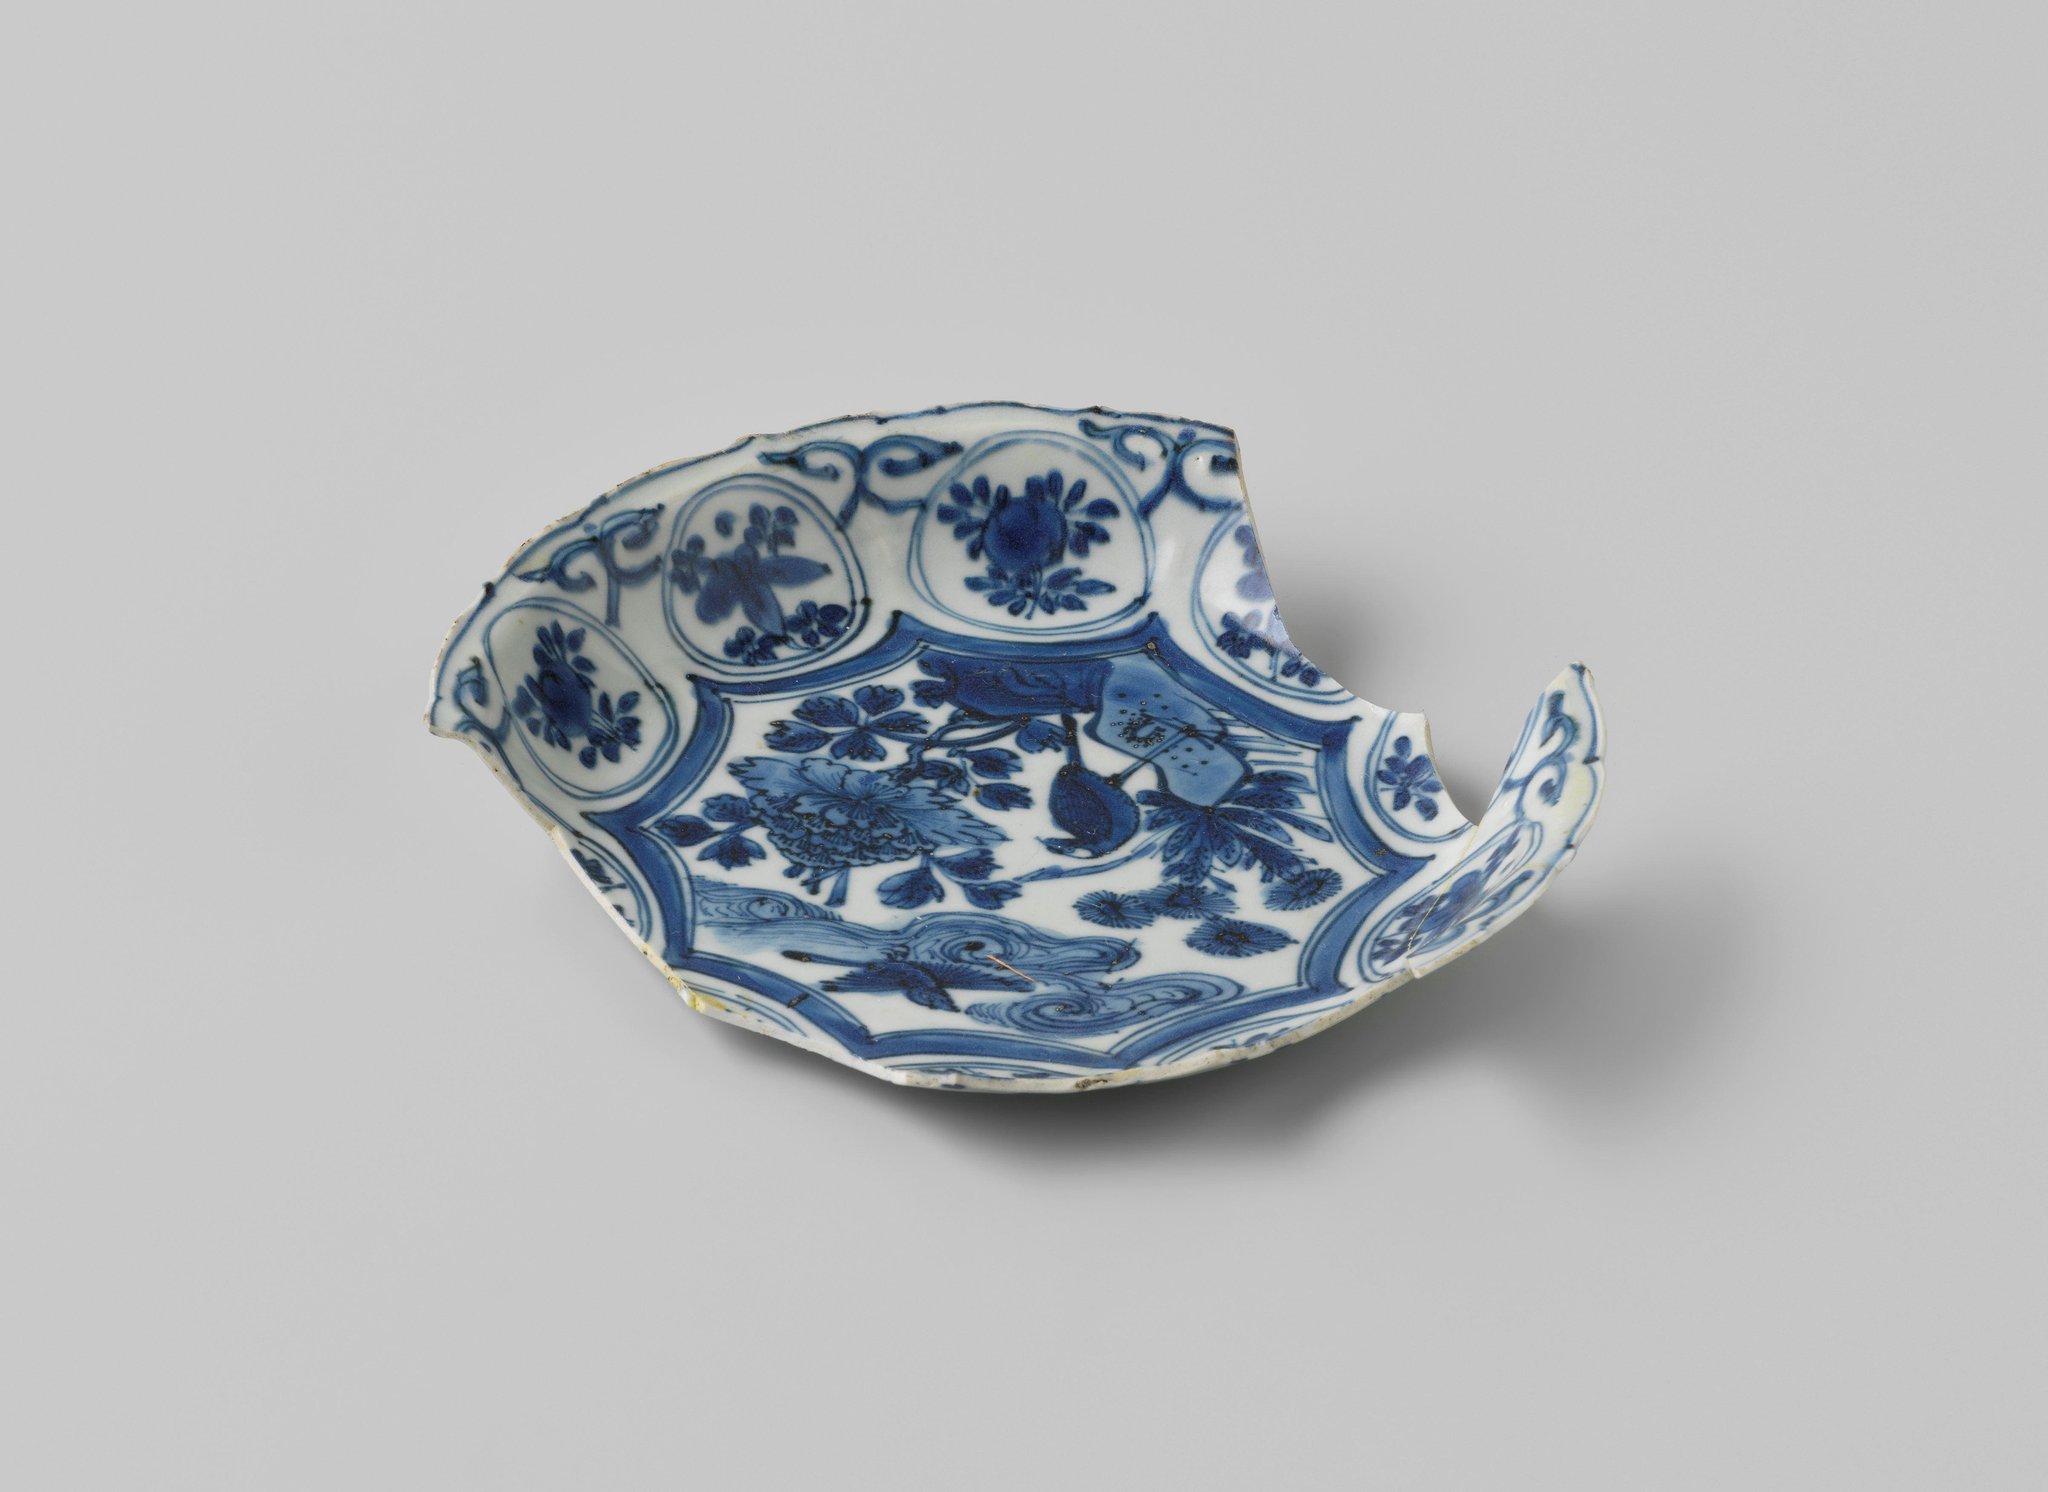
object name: sherd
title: Fragment bord uit V.O.C.-schip de 'Witte Leeuw'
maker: Anonymous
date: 1613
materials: bone china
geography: jingdezhen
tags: verenigde oostindische compagnie, sint-helena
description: A dish without a flattened rim. An eight-sided thickly drawn medallion. A central decoration of one flying bird and one on a rock next to a peony. The medallions decorated with alternately a flower and a peach.